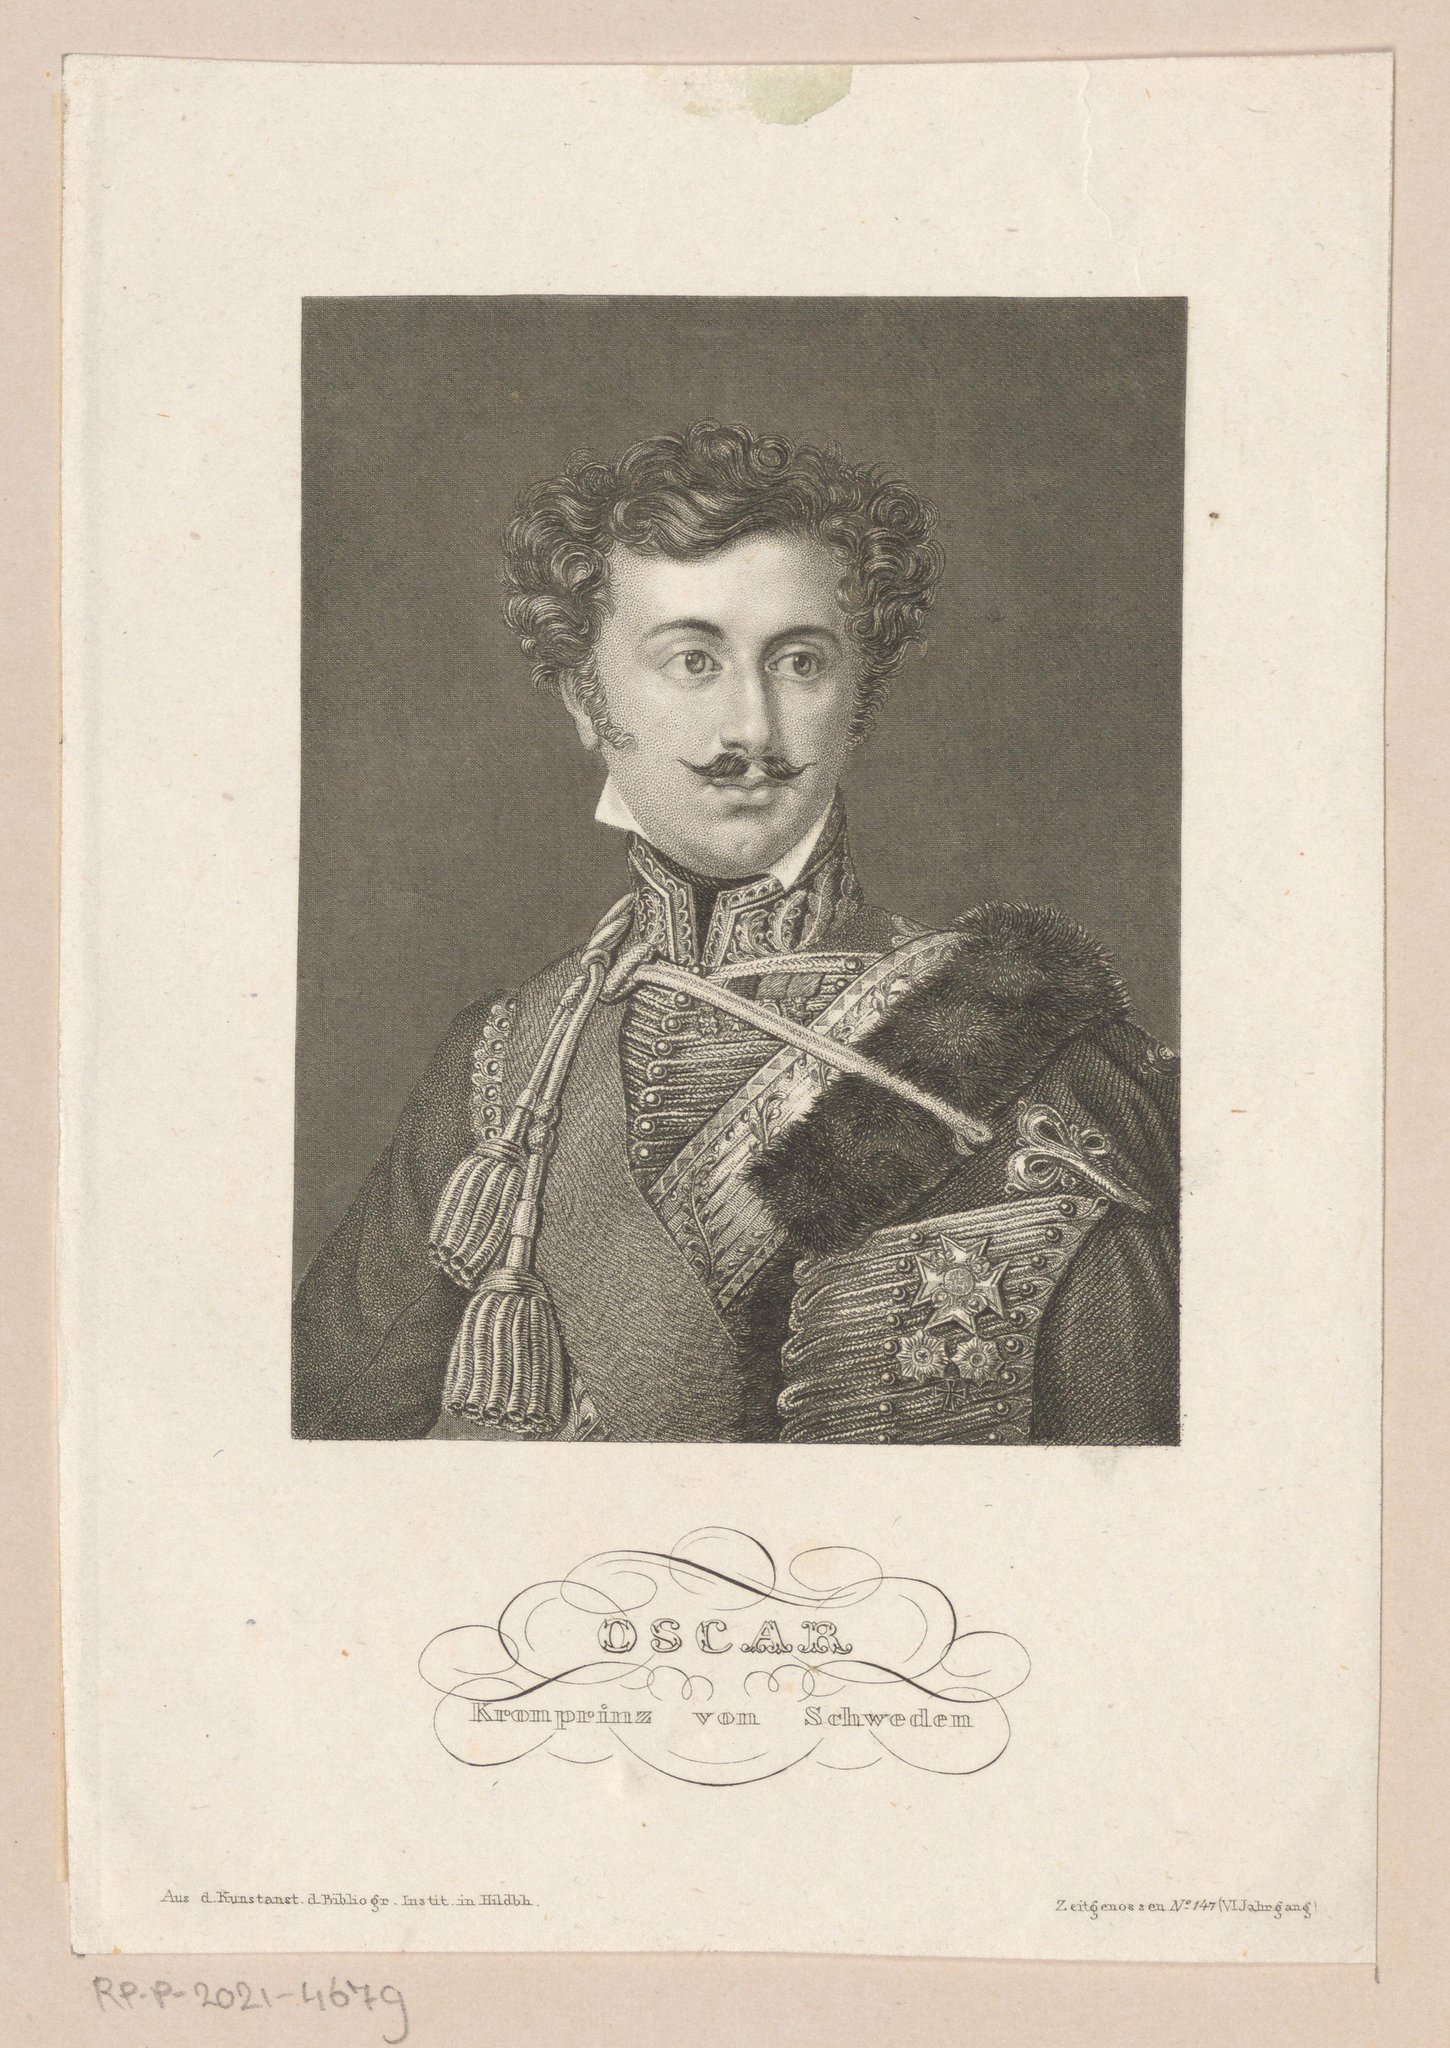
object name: print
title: Tijdgenoten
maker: Anonymous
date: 1829-1840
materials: paper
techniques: engraving, etching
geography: hildburghausen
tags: historical persons, medals and other marks of military honour, king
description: Rechtsonder genummerd: Zeitgenossen no. 147 (VI Jahrgang).